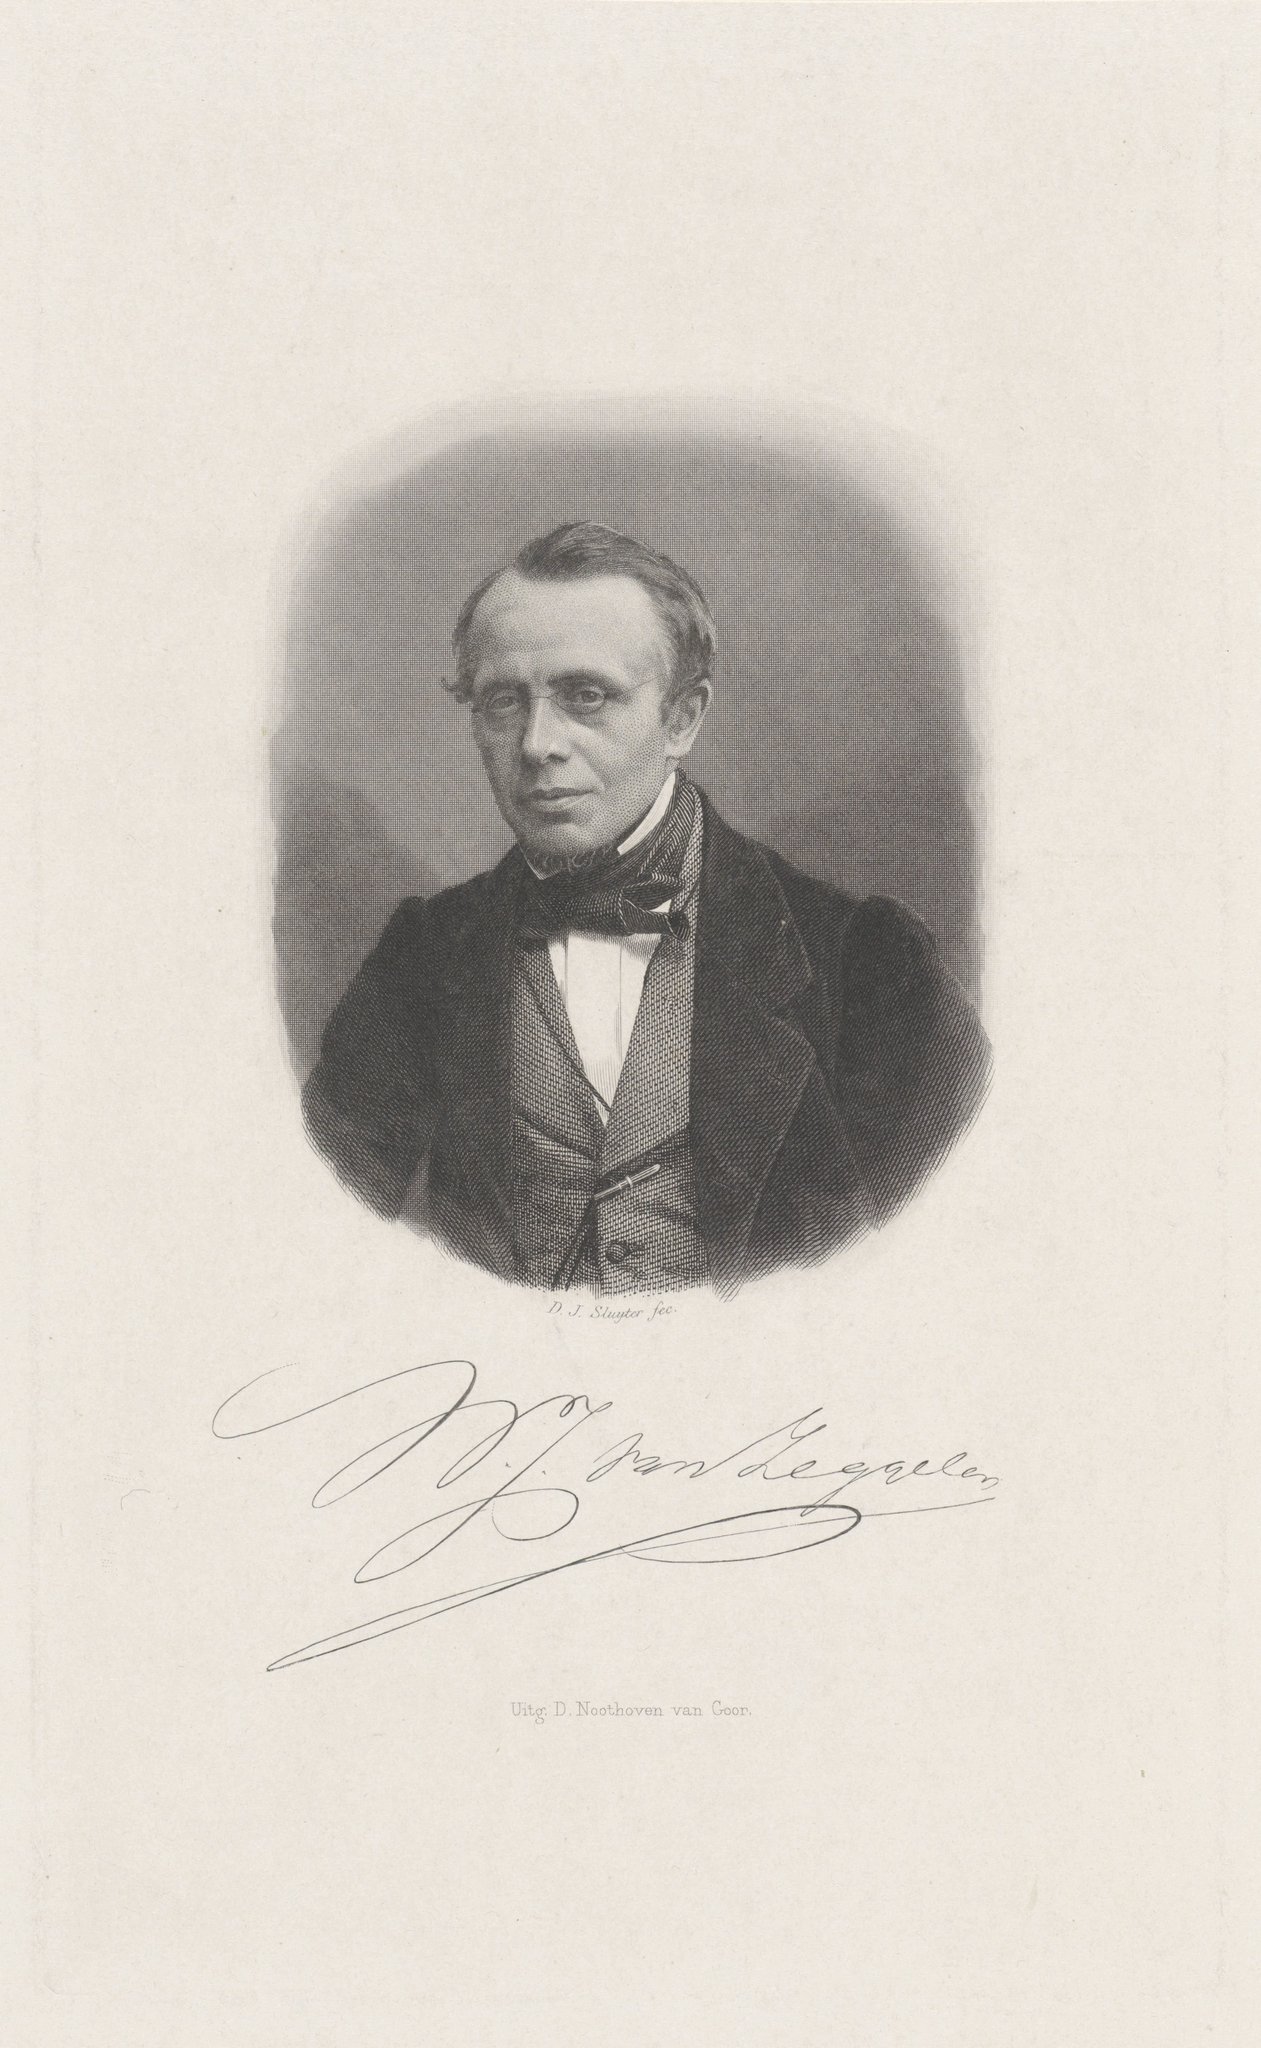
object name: print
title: Portret van de dichter en boekdrukker Willem Josephus van Zeggelen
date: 1848-1885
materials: paper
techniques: aquatint, etching, engraving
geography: amsterdam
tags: the hague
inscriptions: collector's mark: Lugt 2228